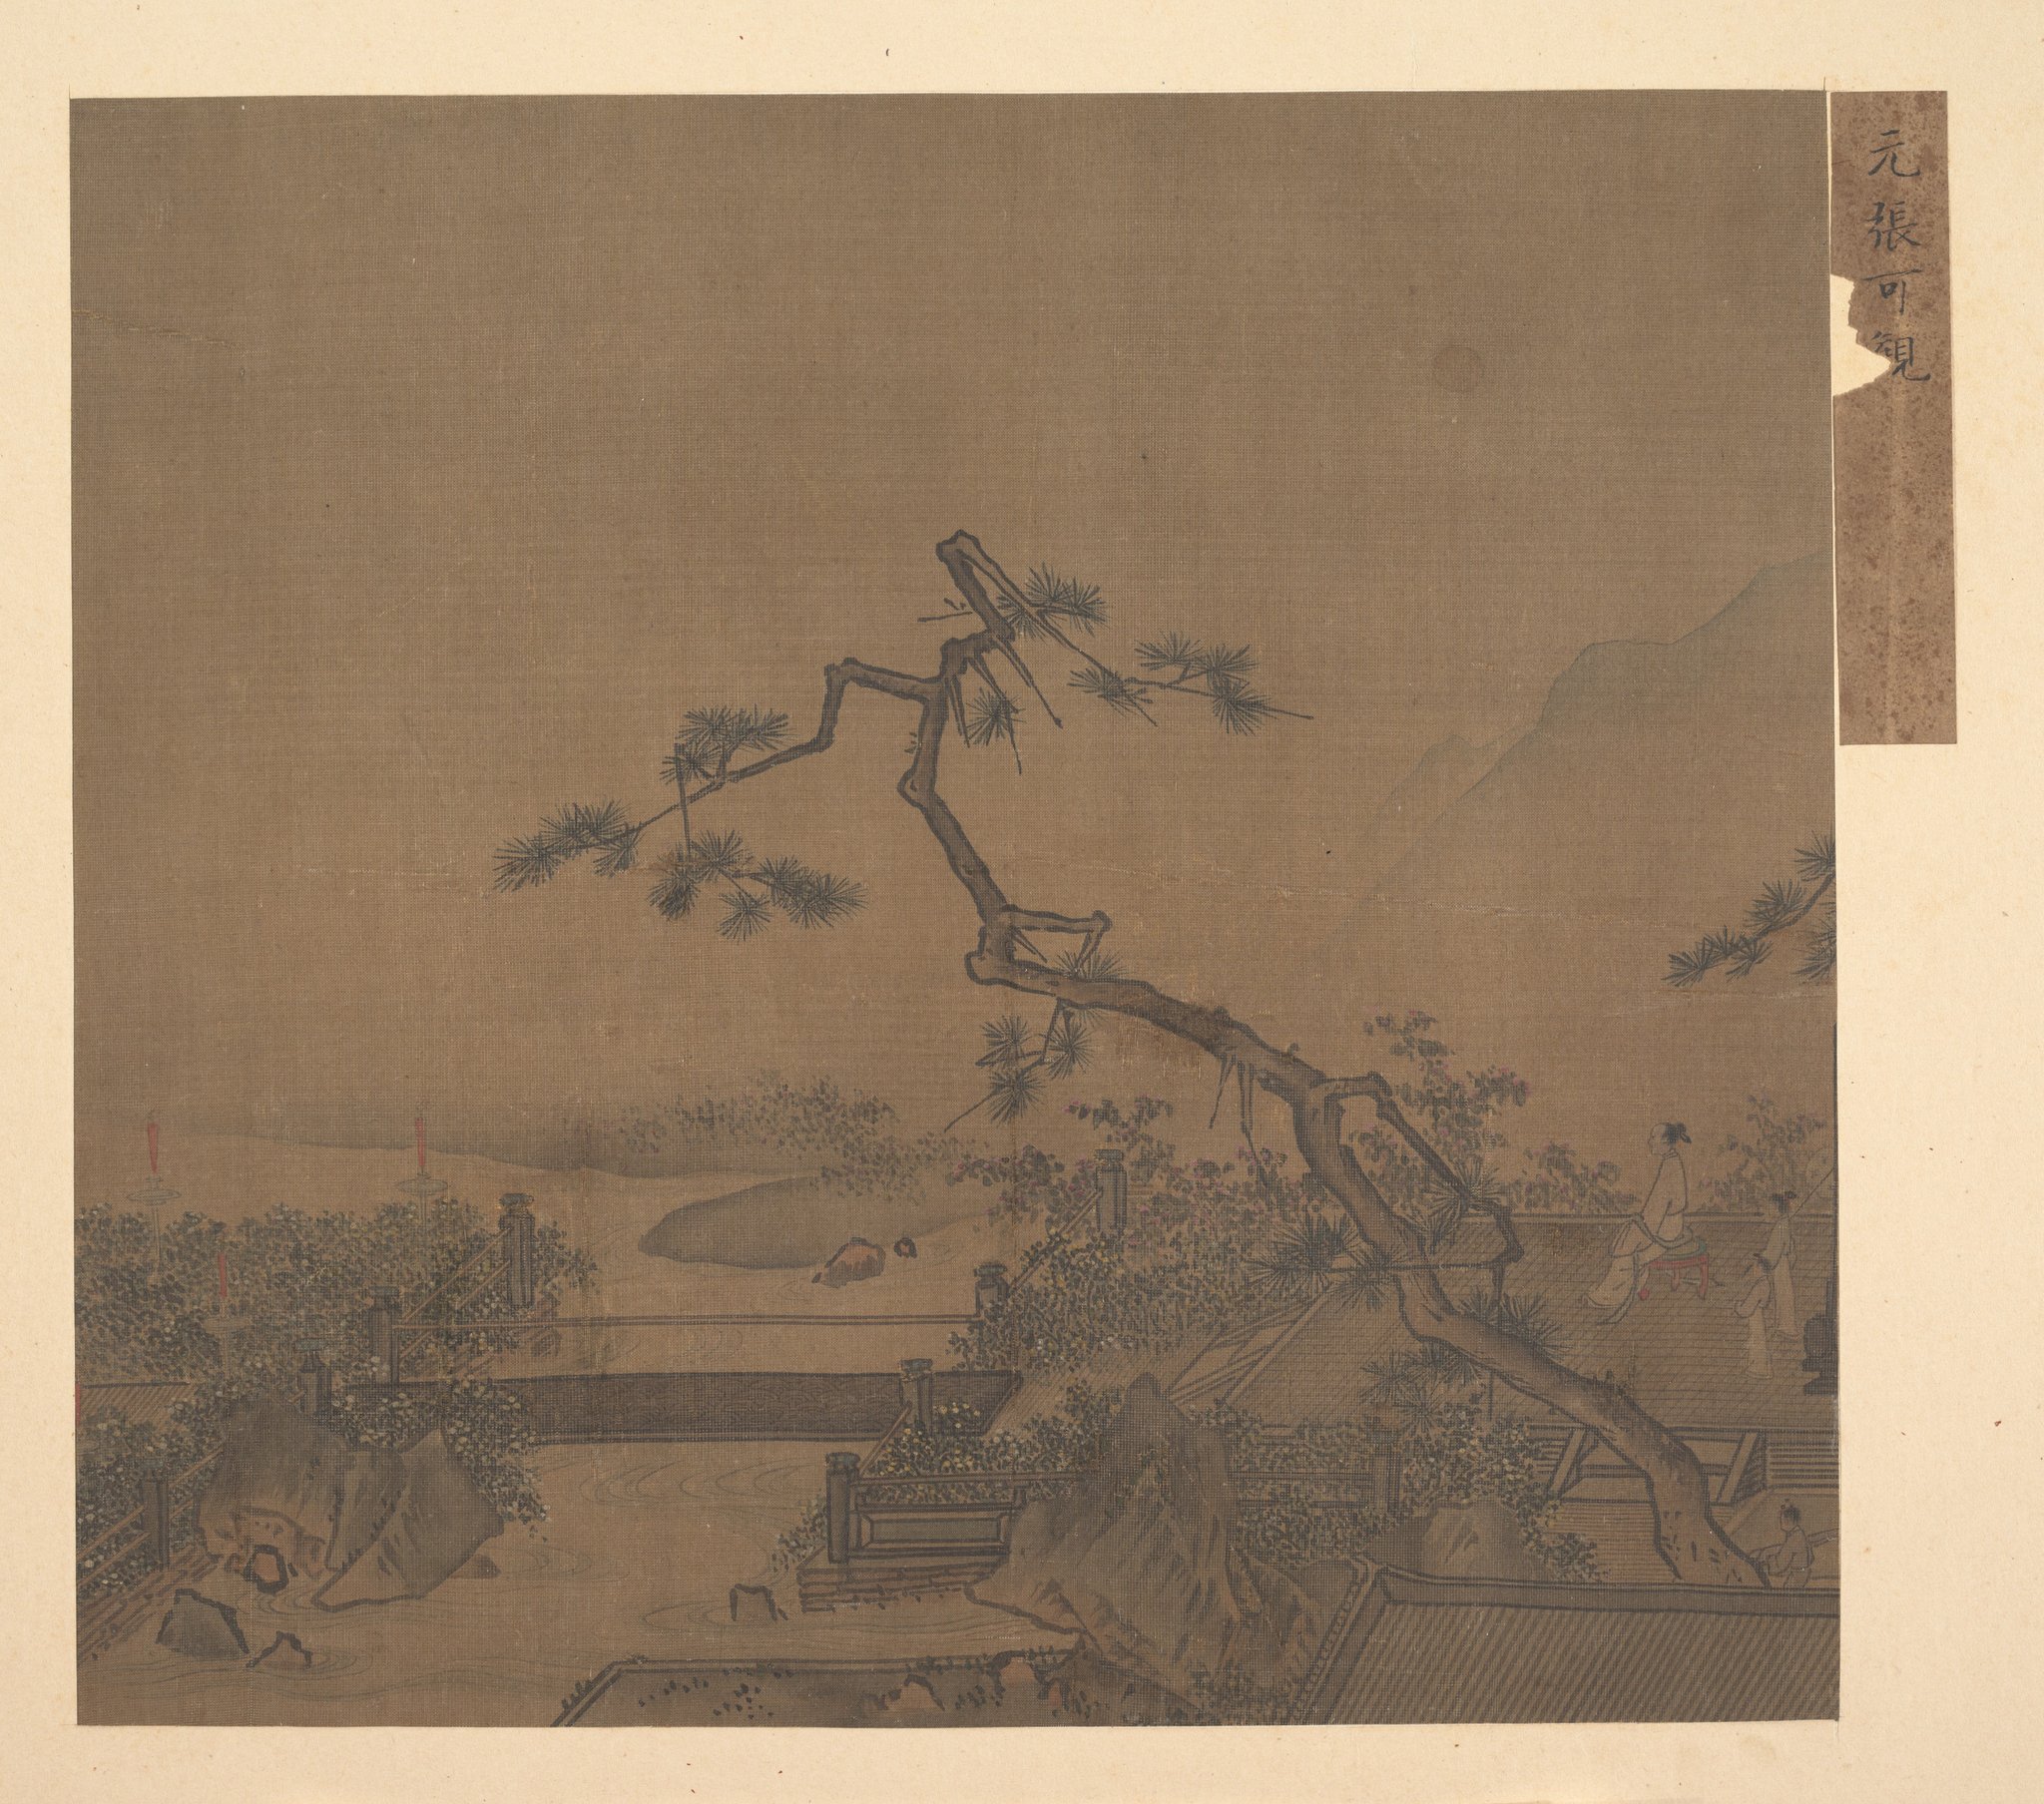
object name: album leaf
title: Moonlit terrace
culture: chinese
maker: unidentified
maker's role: artist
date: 1601-1700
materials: ink, silk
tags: human figures,landscapes